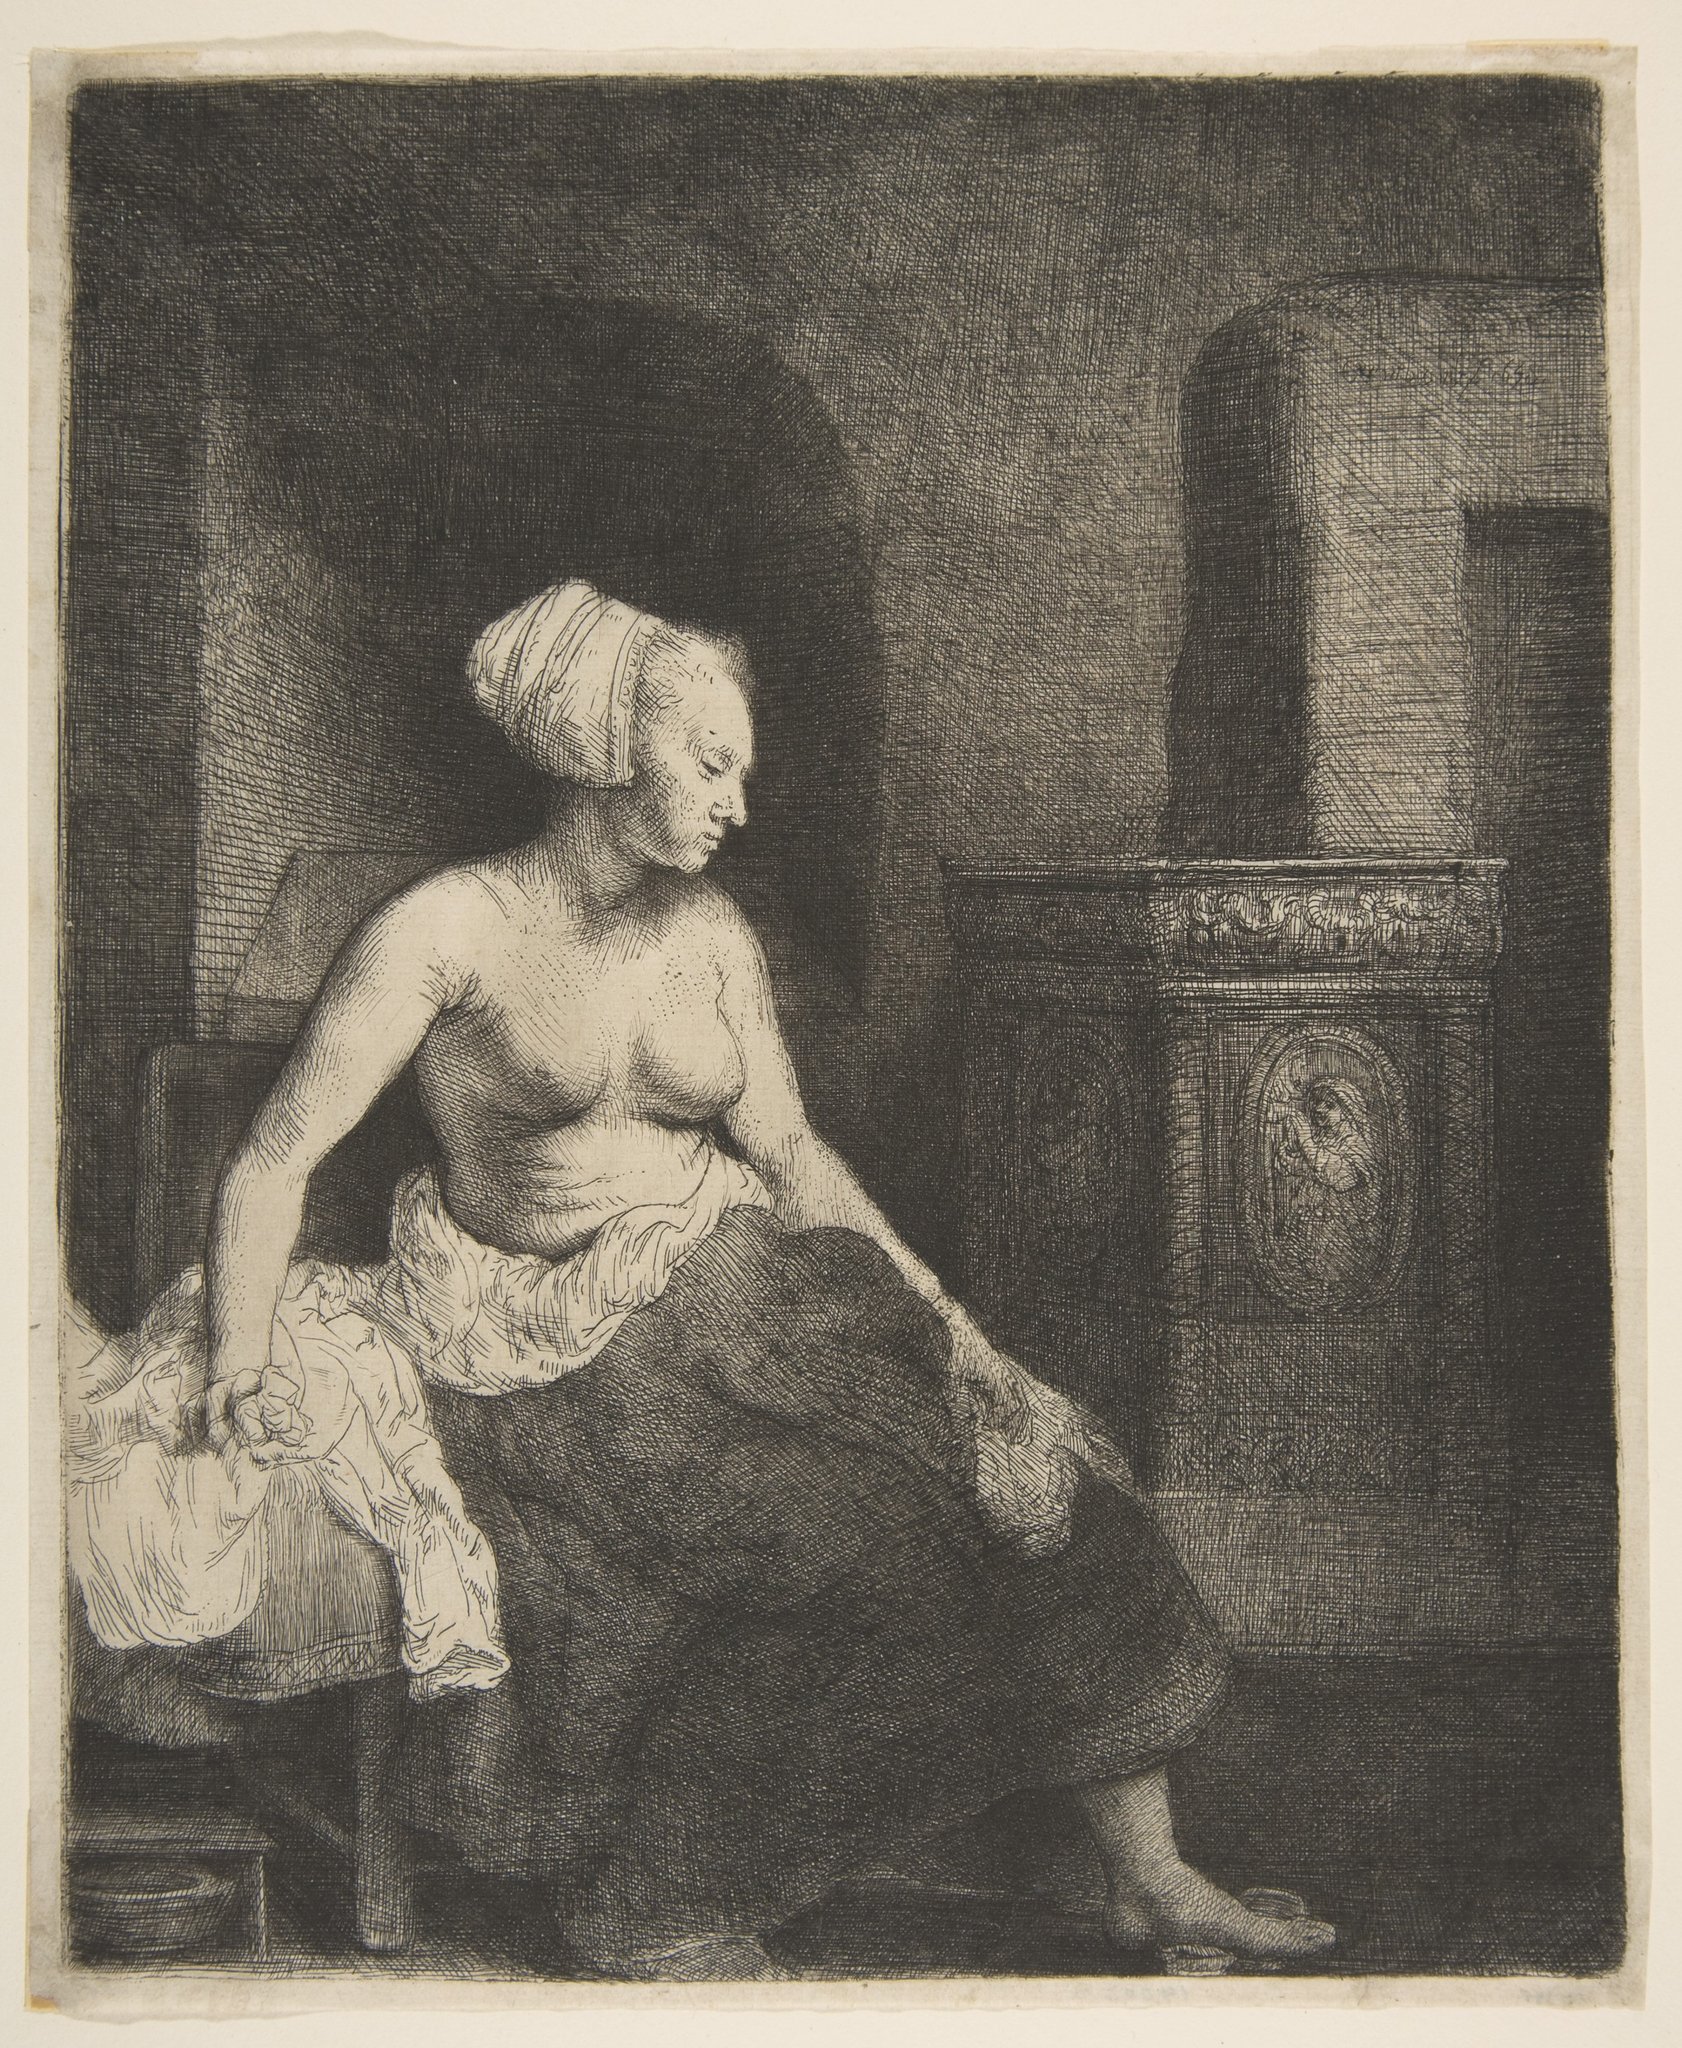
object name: print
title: Woman Sitting Half-Dressed beside a Stove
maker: rembrandt van rijn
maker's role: artist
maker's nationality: dutch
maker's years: 1606-1669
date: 1658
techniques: drypoint, etching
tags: female nudes